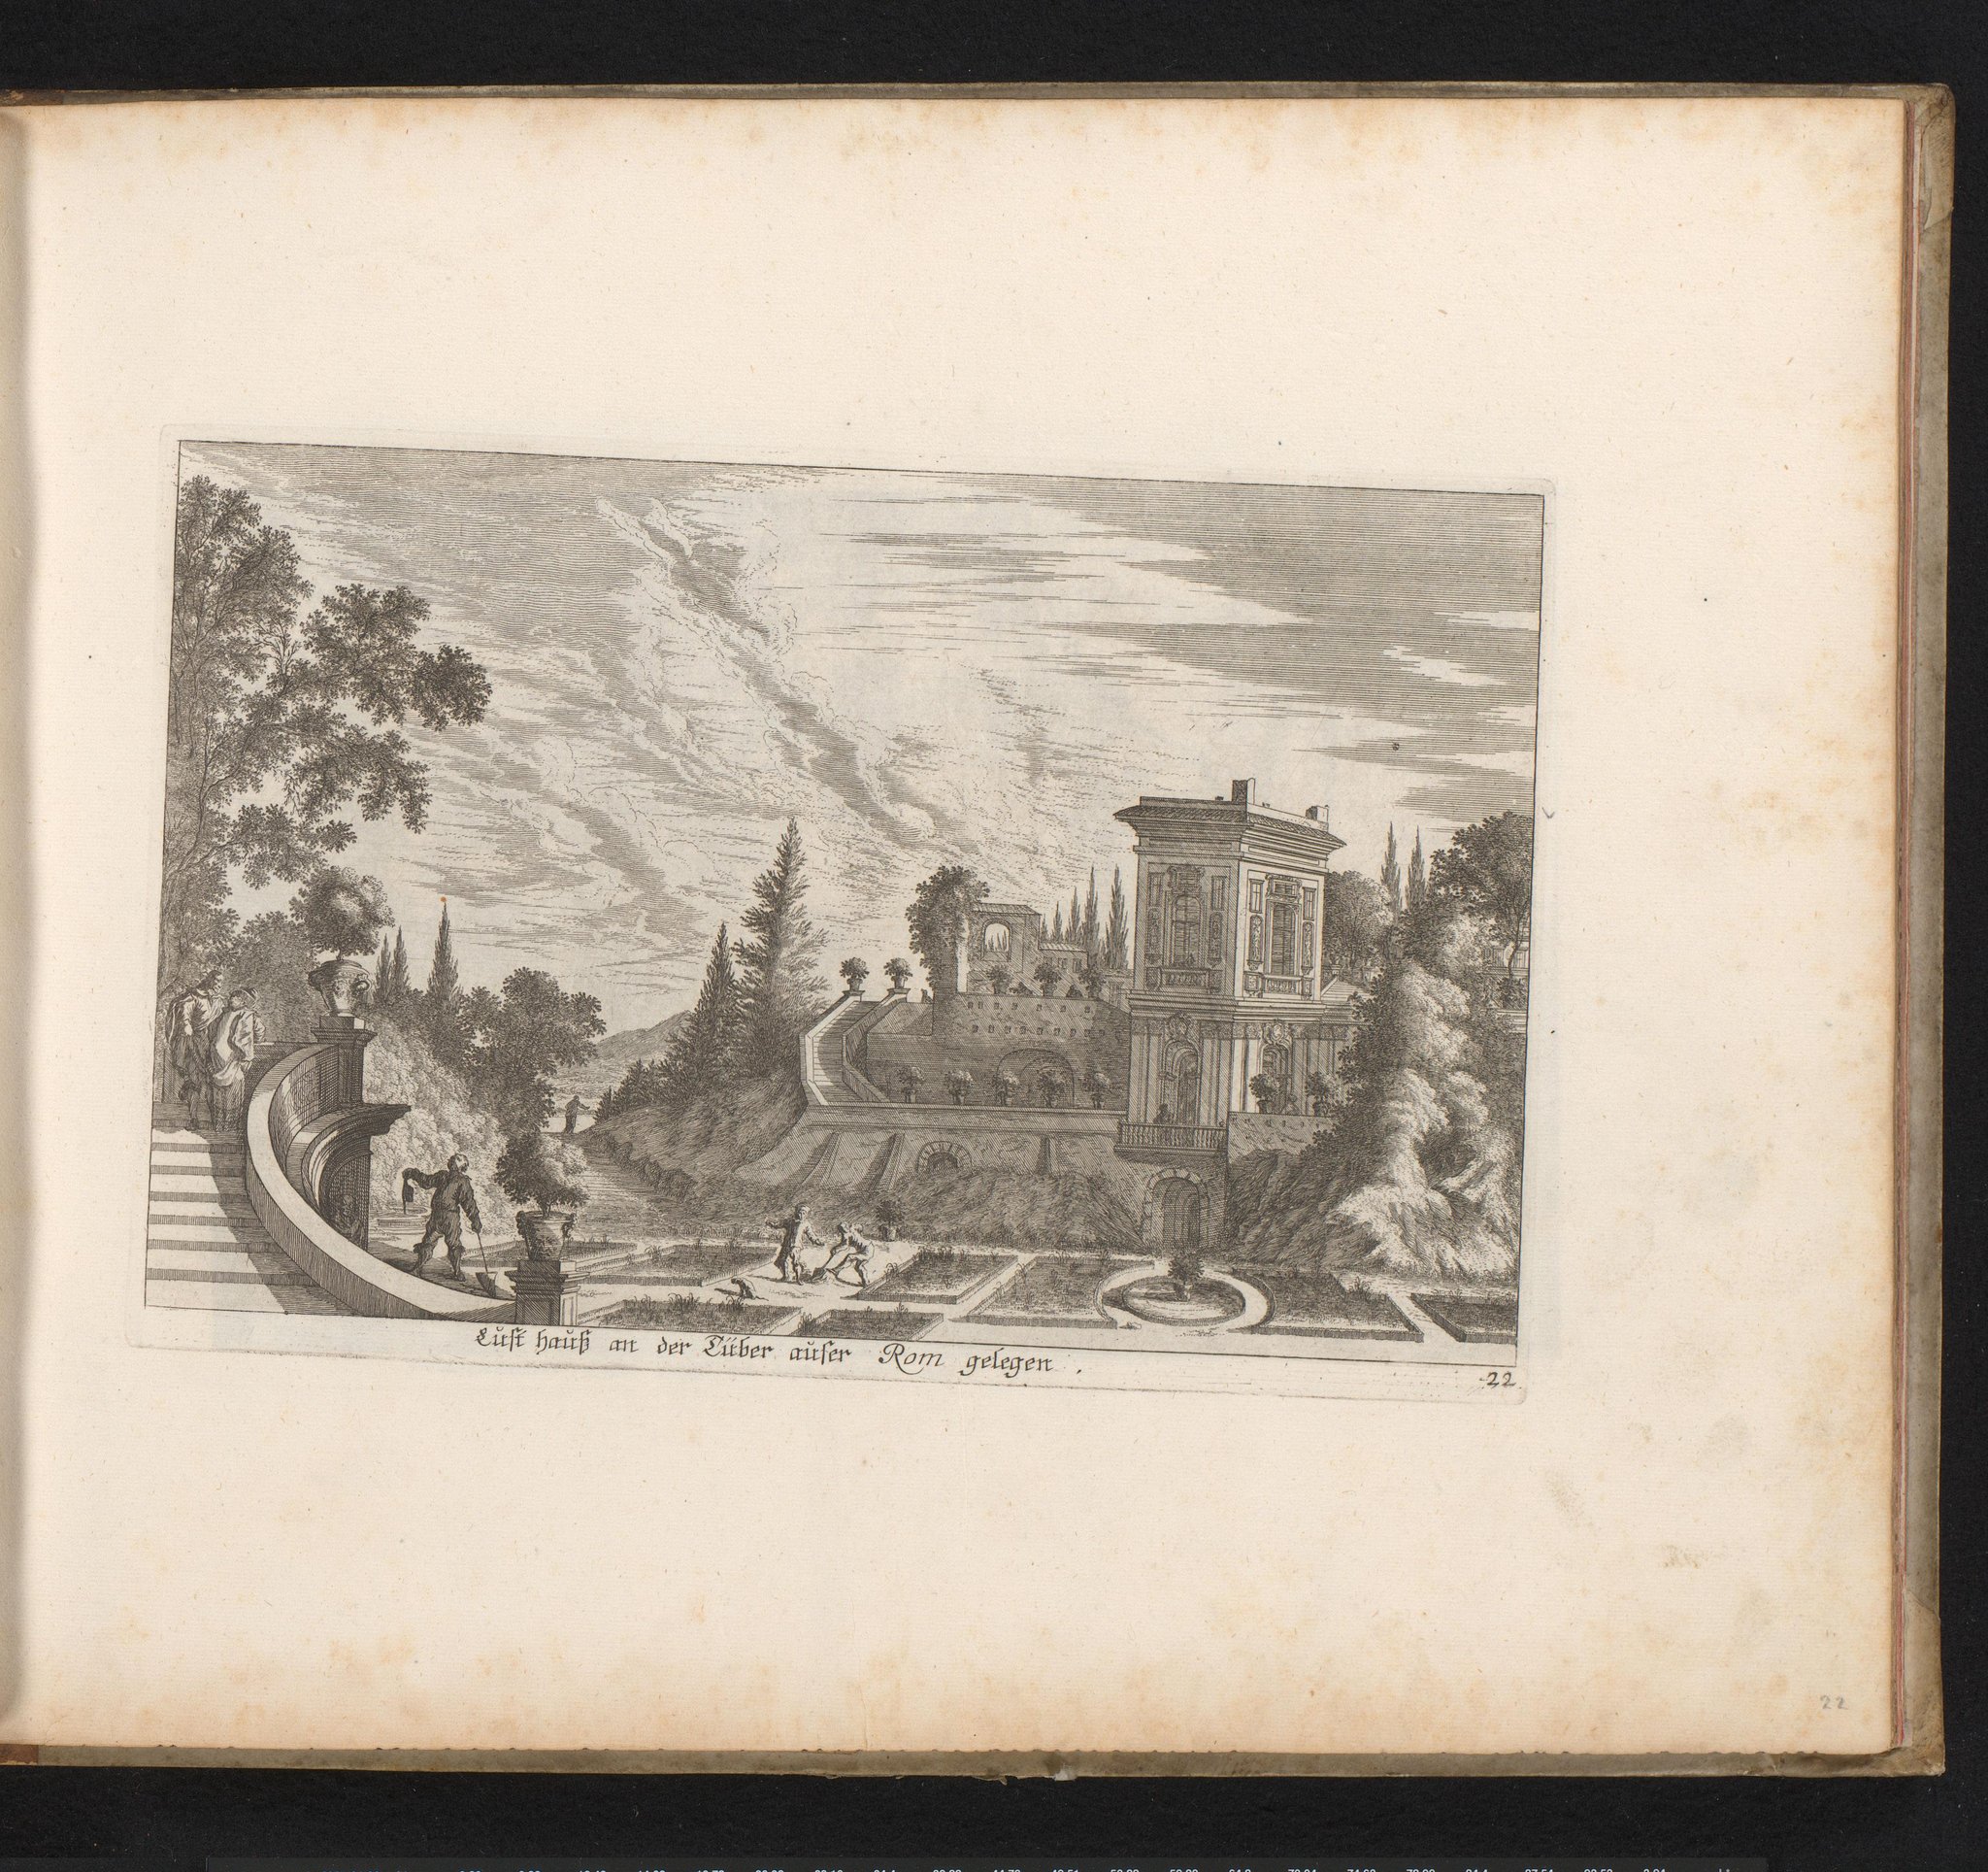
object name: album leaf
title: Gezicht op een palazzo gelegen aan de Tiber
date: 1670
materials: paper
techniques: etching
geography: augsburg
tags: hôtel, i.e. small palace in city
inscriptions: collector's mark: Lugt 2228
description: Tekst in het Duits in de ondermarge. Rechtsonder genummerd: 22. Prent maakt deel uit van een album.